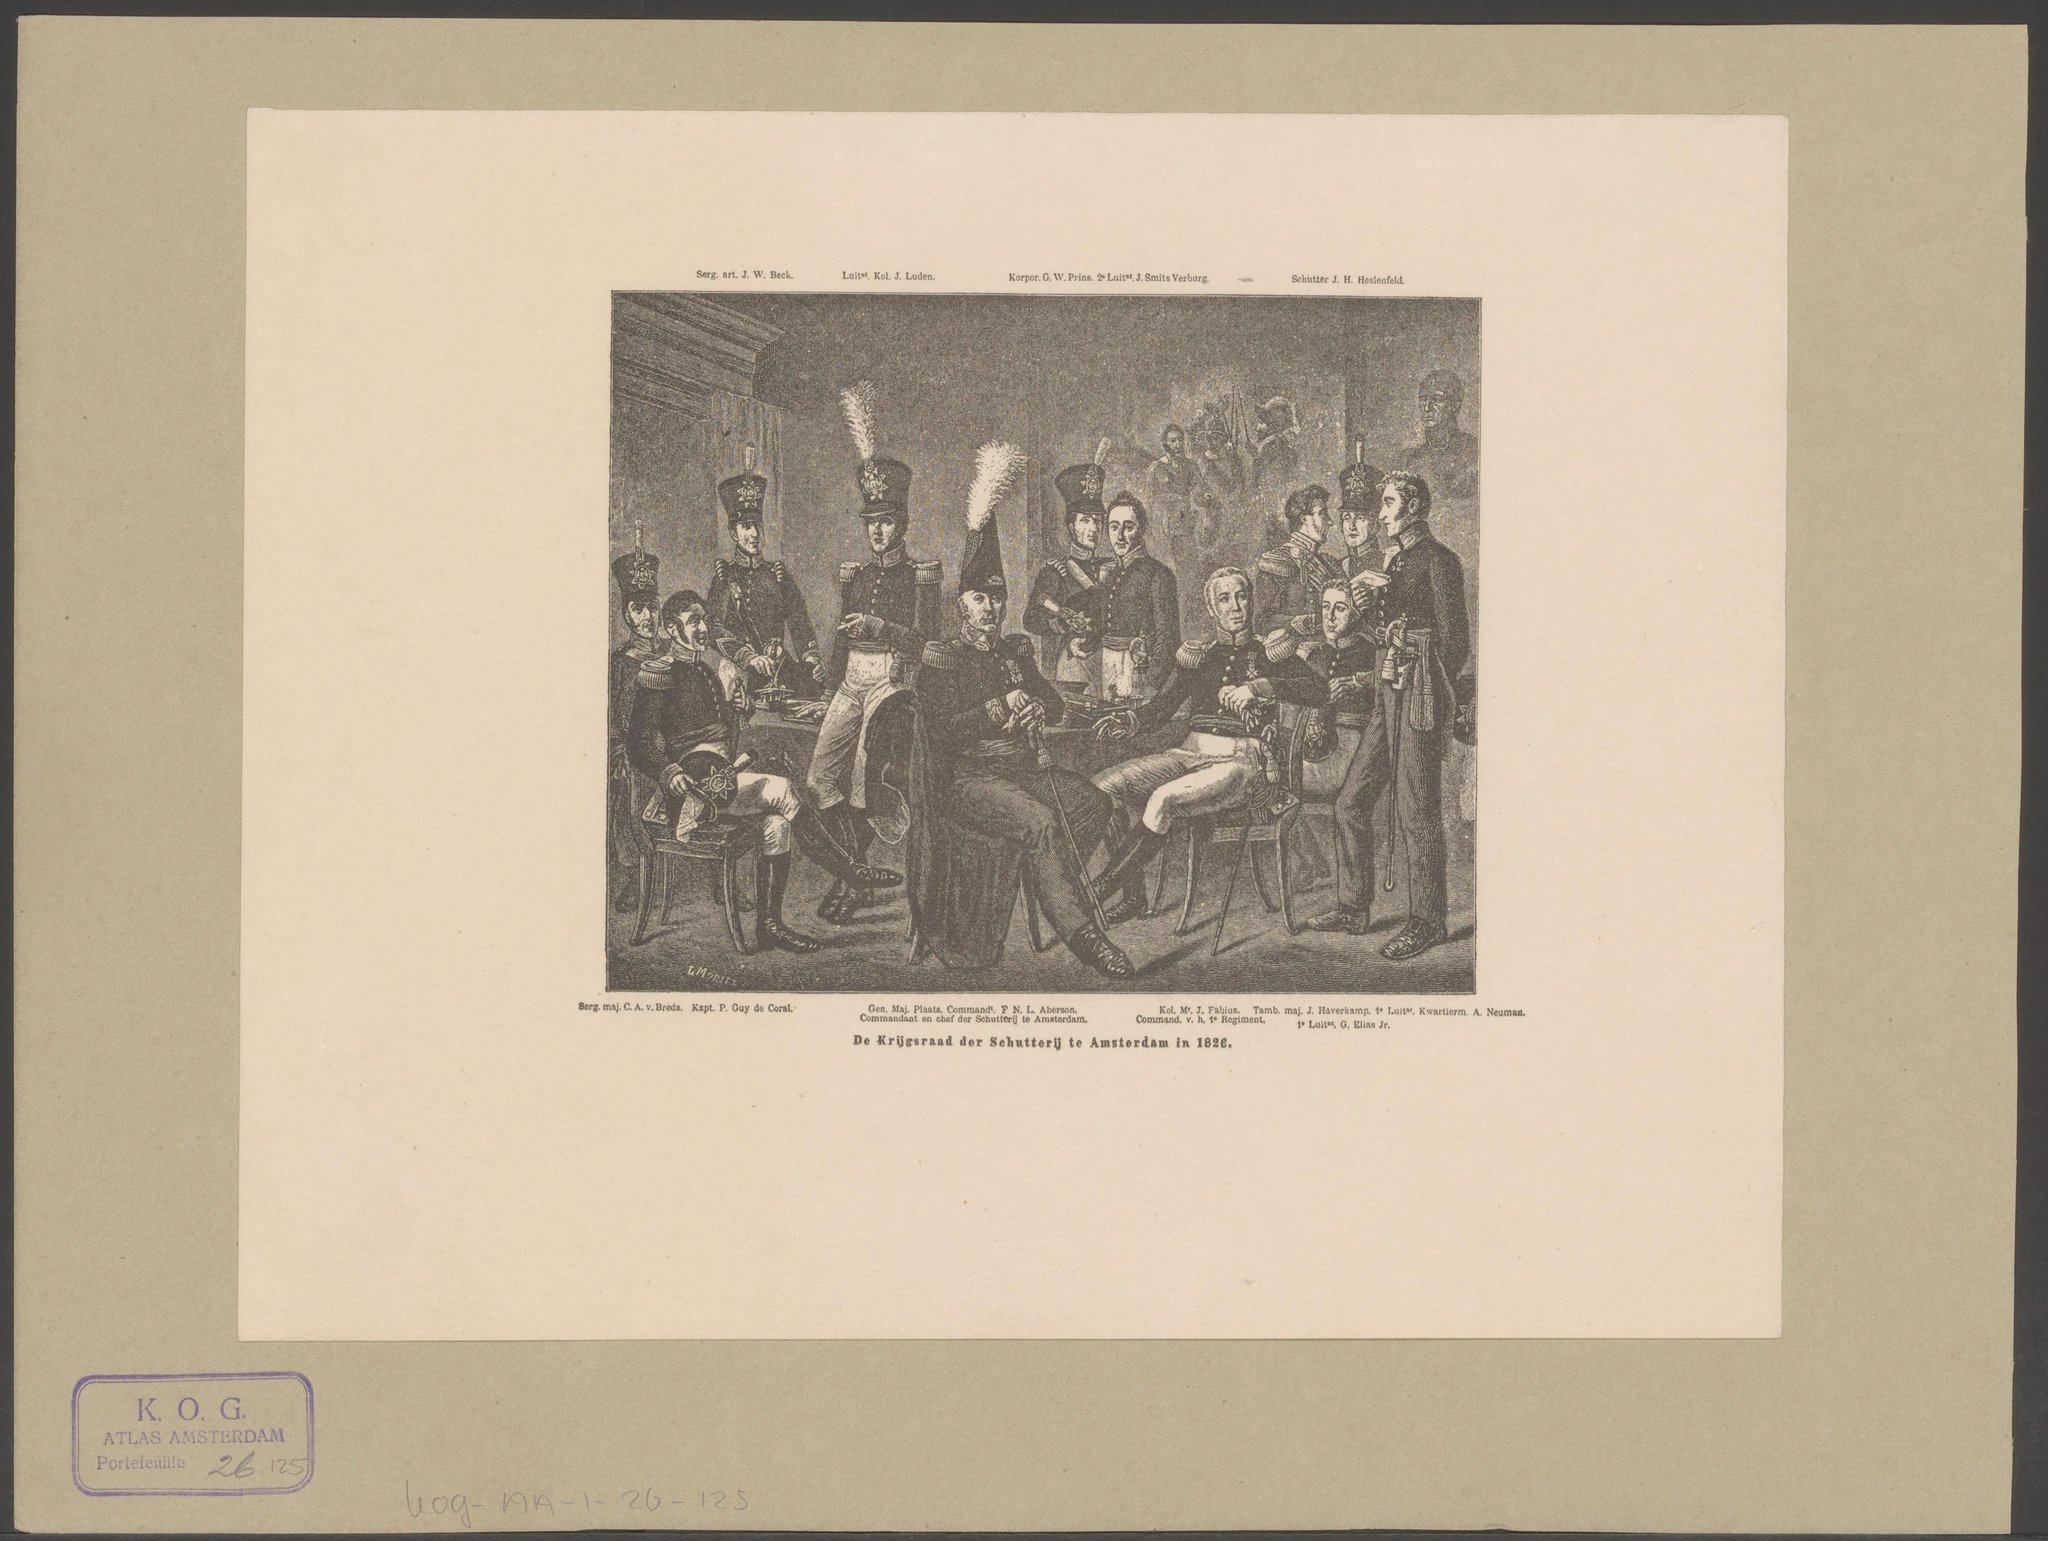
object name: print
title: Krijgsraad van de Amsterdamse schutterij in 1826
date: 1890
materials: paper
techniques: letterpress printing, engraving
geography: amsterdam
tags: amsterdam, politician, historical persons, military service (+ citizen soldiery, civil guard, citizen militia)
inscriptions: collector's mark: Lugt 1641b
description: Prent mogelijk uit: Jochems, John Anthony. Gewapende Burgermacht te Amsterdam (Schutterij) 1796-1889. Amsterdam: Stadsdrukkerij, 1890.